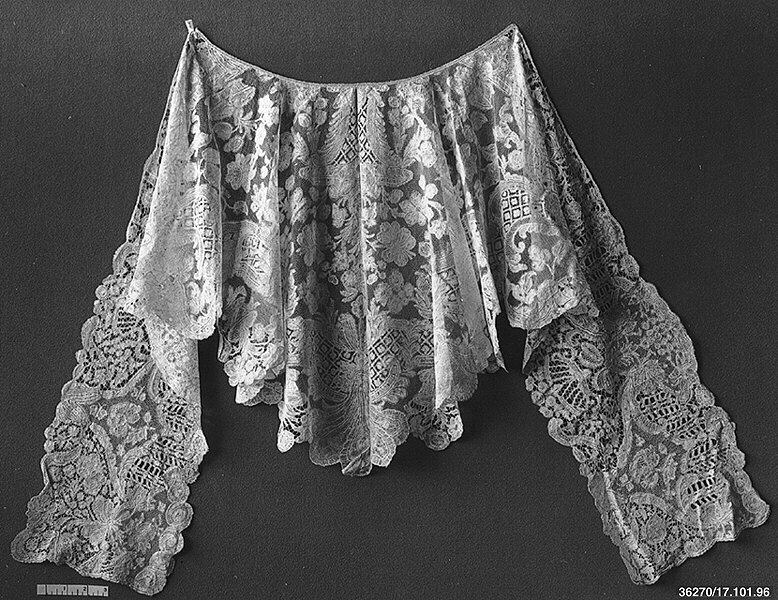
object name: cape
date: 1700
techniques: lace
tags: flowers